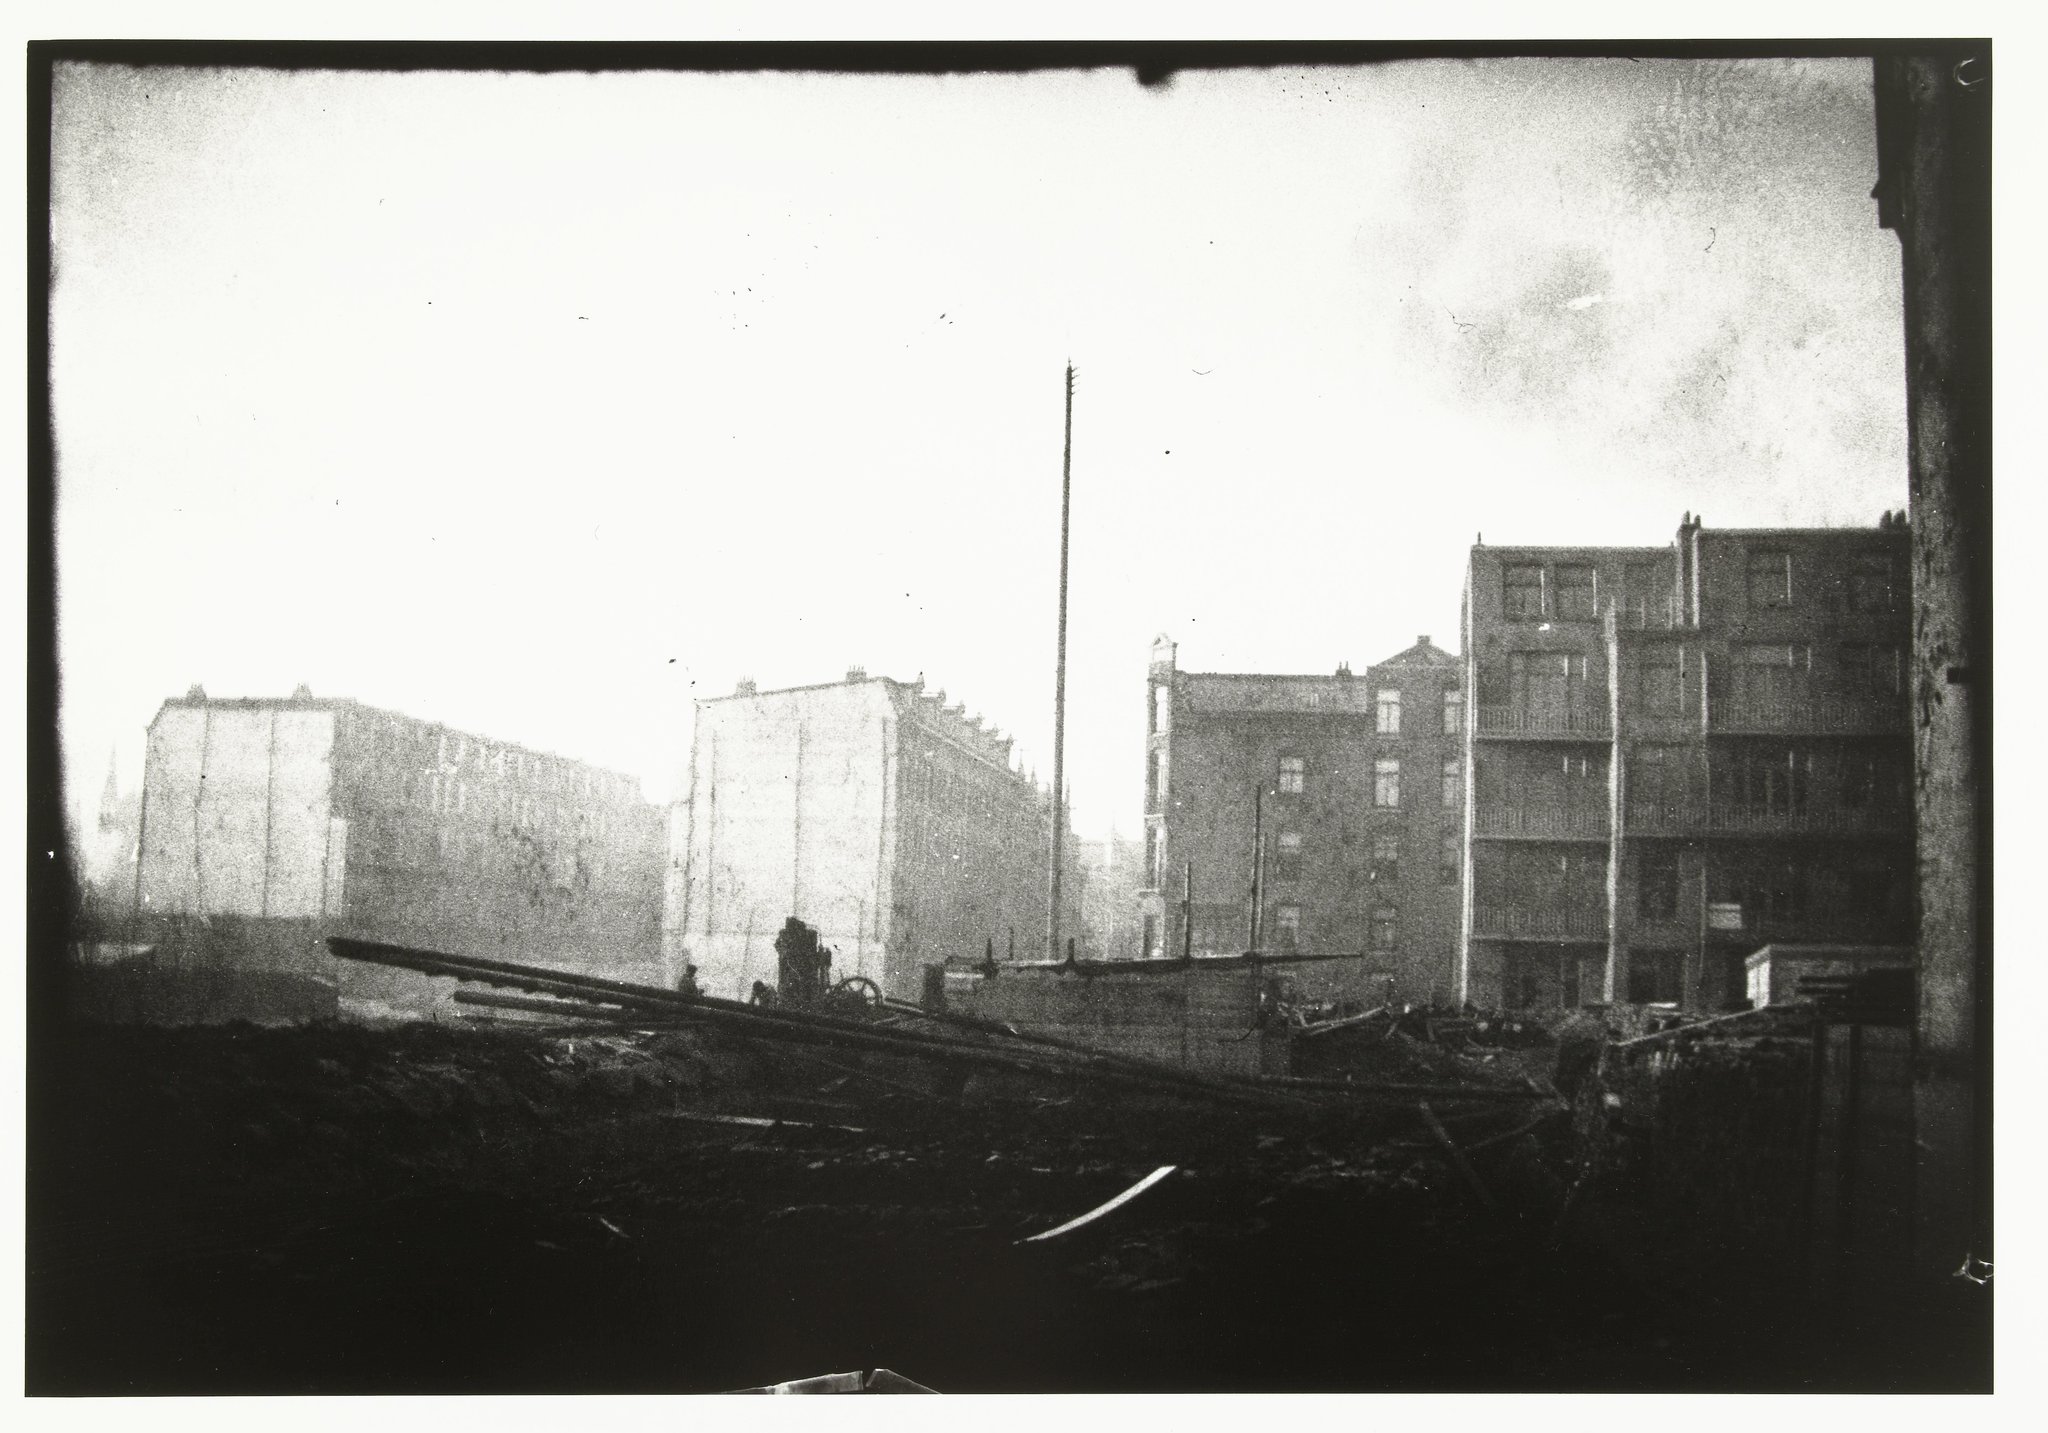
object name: photograph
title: Nieuwbouw langs het Jacob van Lennepkanaal in Amsterdam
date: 1890-1910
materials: paper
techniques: gelatin silver print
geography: amsterdam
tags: amsterdam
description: Moderne afdruk van negatief BR 858 (collectie RKD).